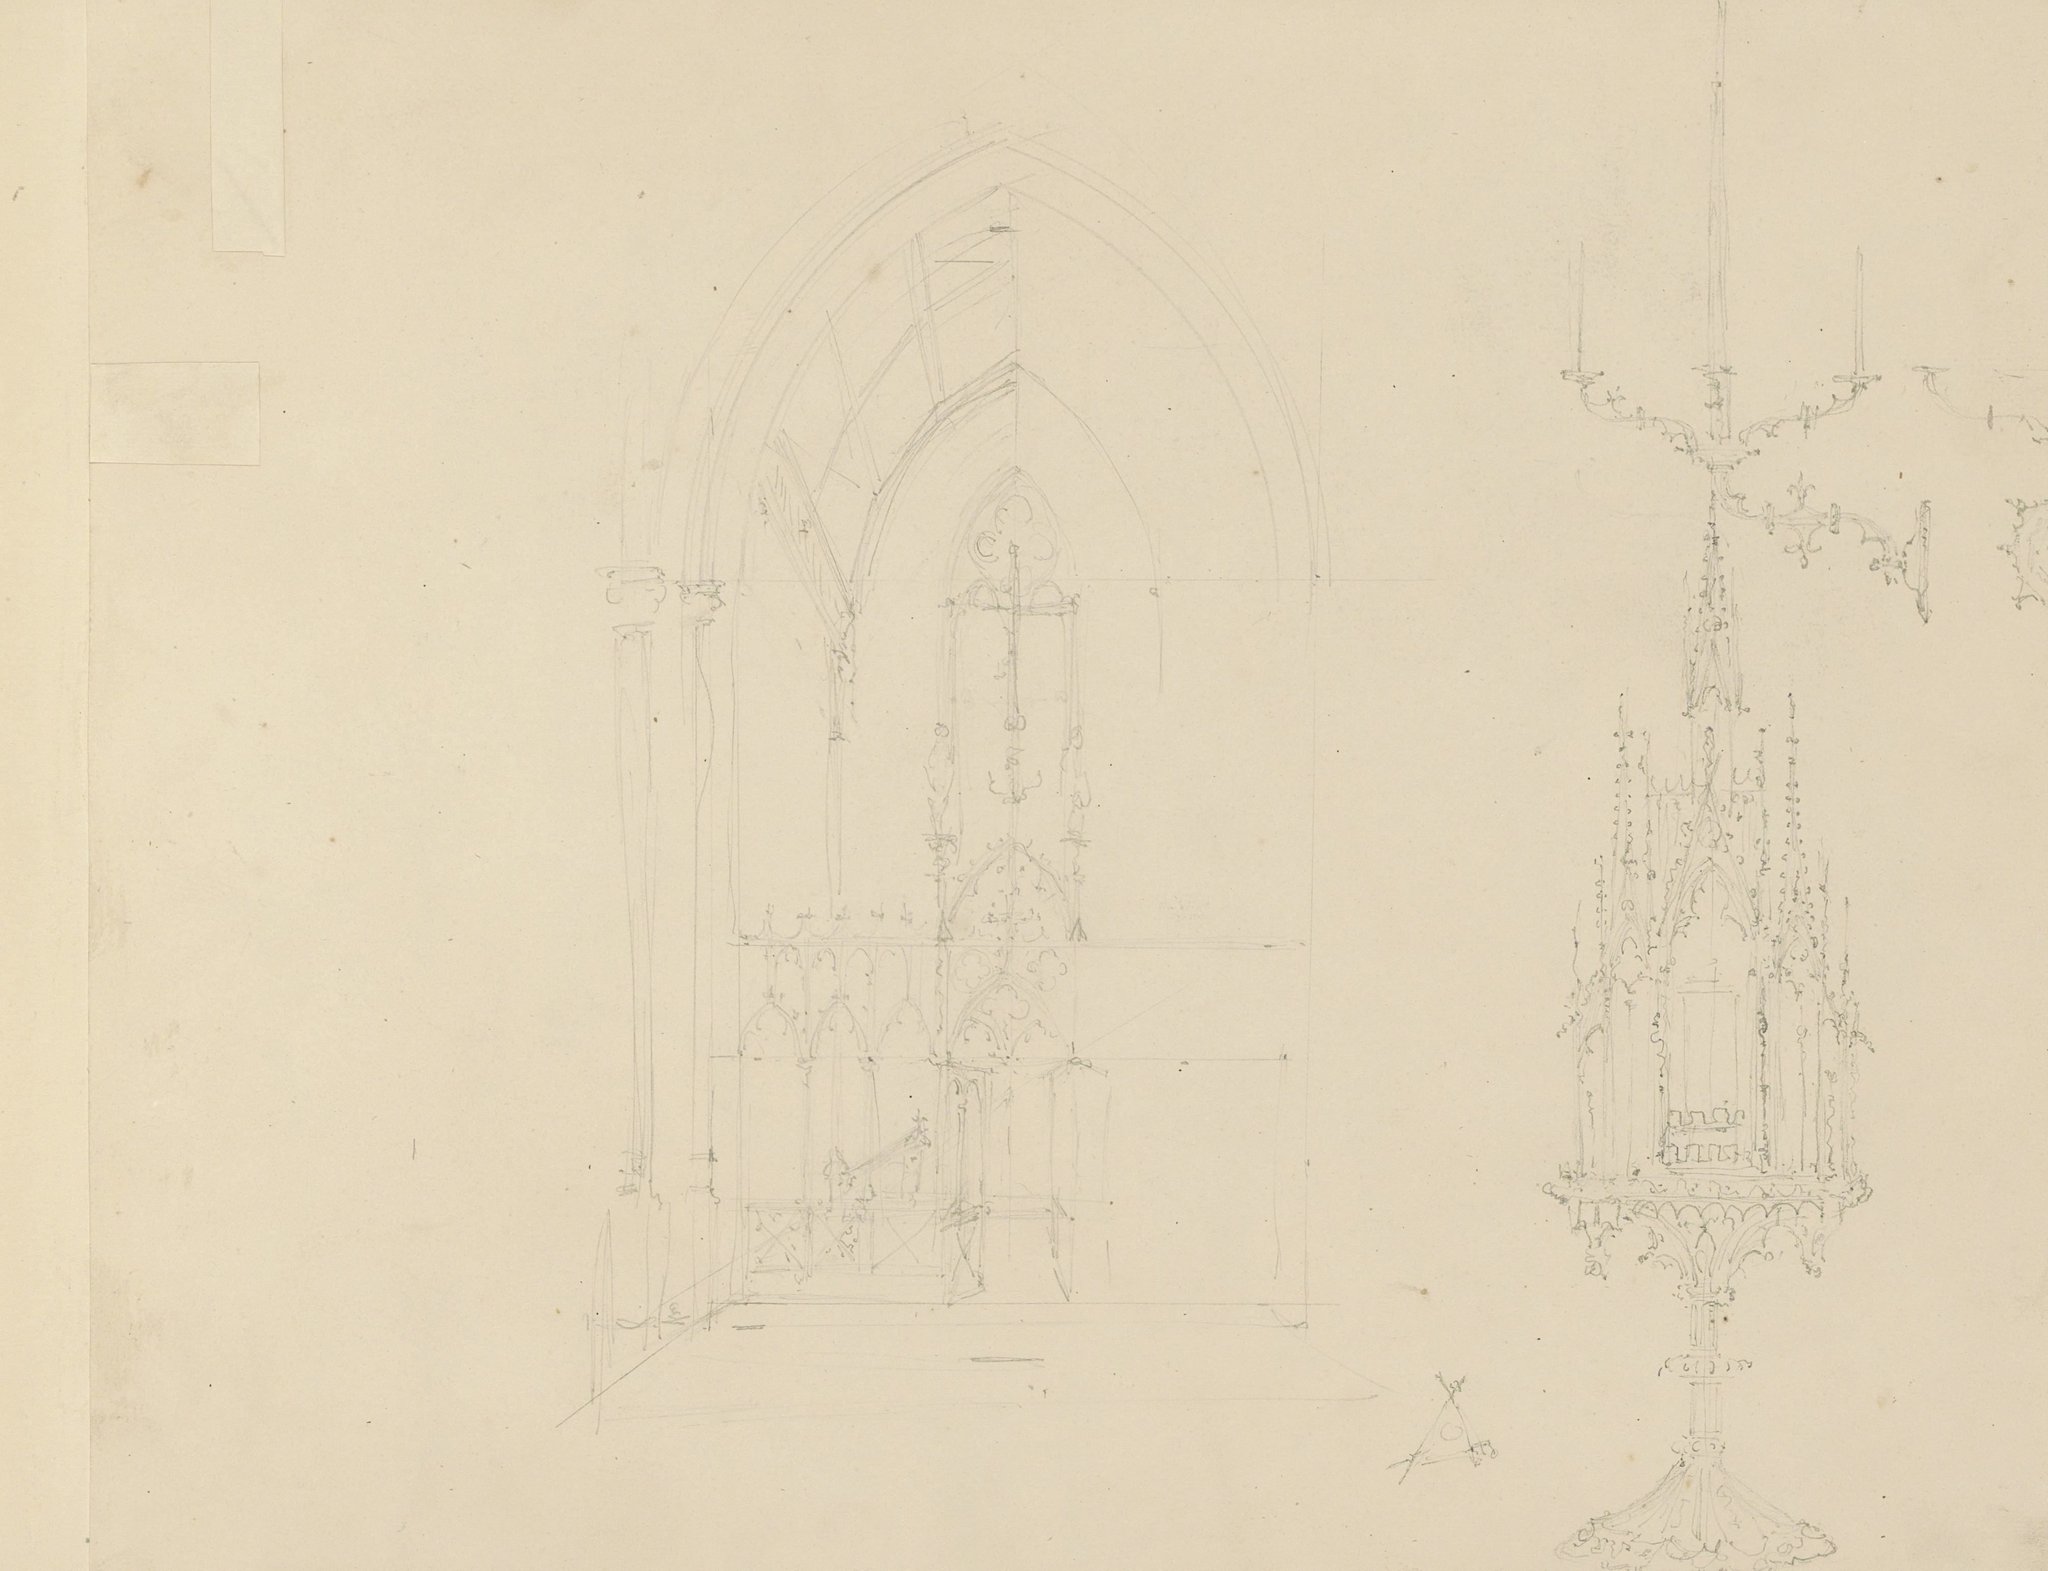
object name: sketchbook leaf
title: Reliekschrijn, kandelaars en een gezicht op het koor van een kerk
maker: pierre joseph hubert cuypers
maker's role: draughtsman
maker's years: 1827-1921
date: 1850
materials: paper, pencil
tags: relics (and reliquaries), parts of church interior: choir, candlestick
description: Blad 35 recto uit een schetsboek met 37 bladen.